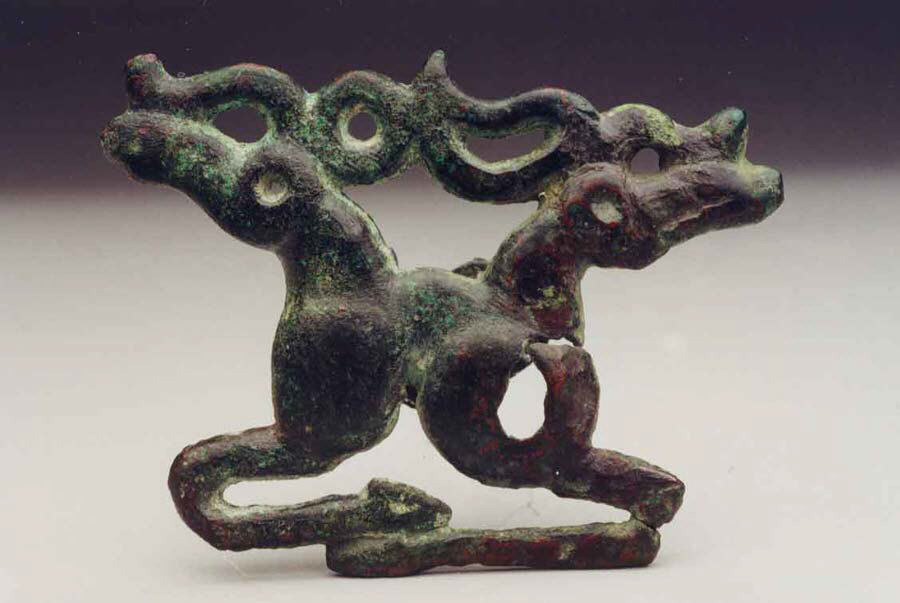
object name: garment plaque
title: Deer-Shaped Garment Plaque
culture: kazakh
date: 600-301 BCE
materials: bronze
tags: deer